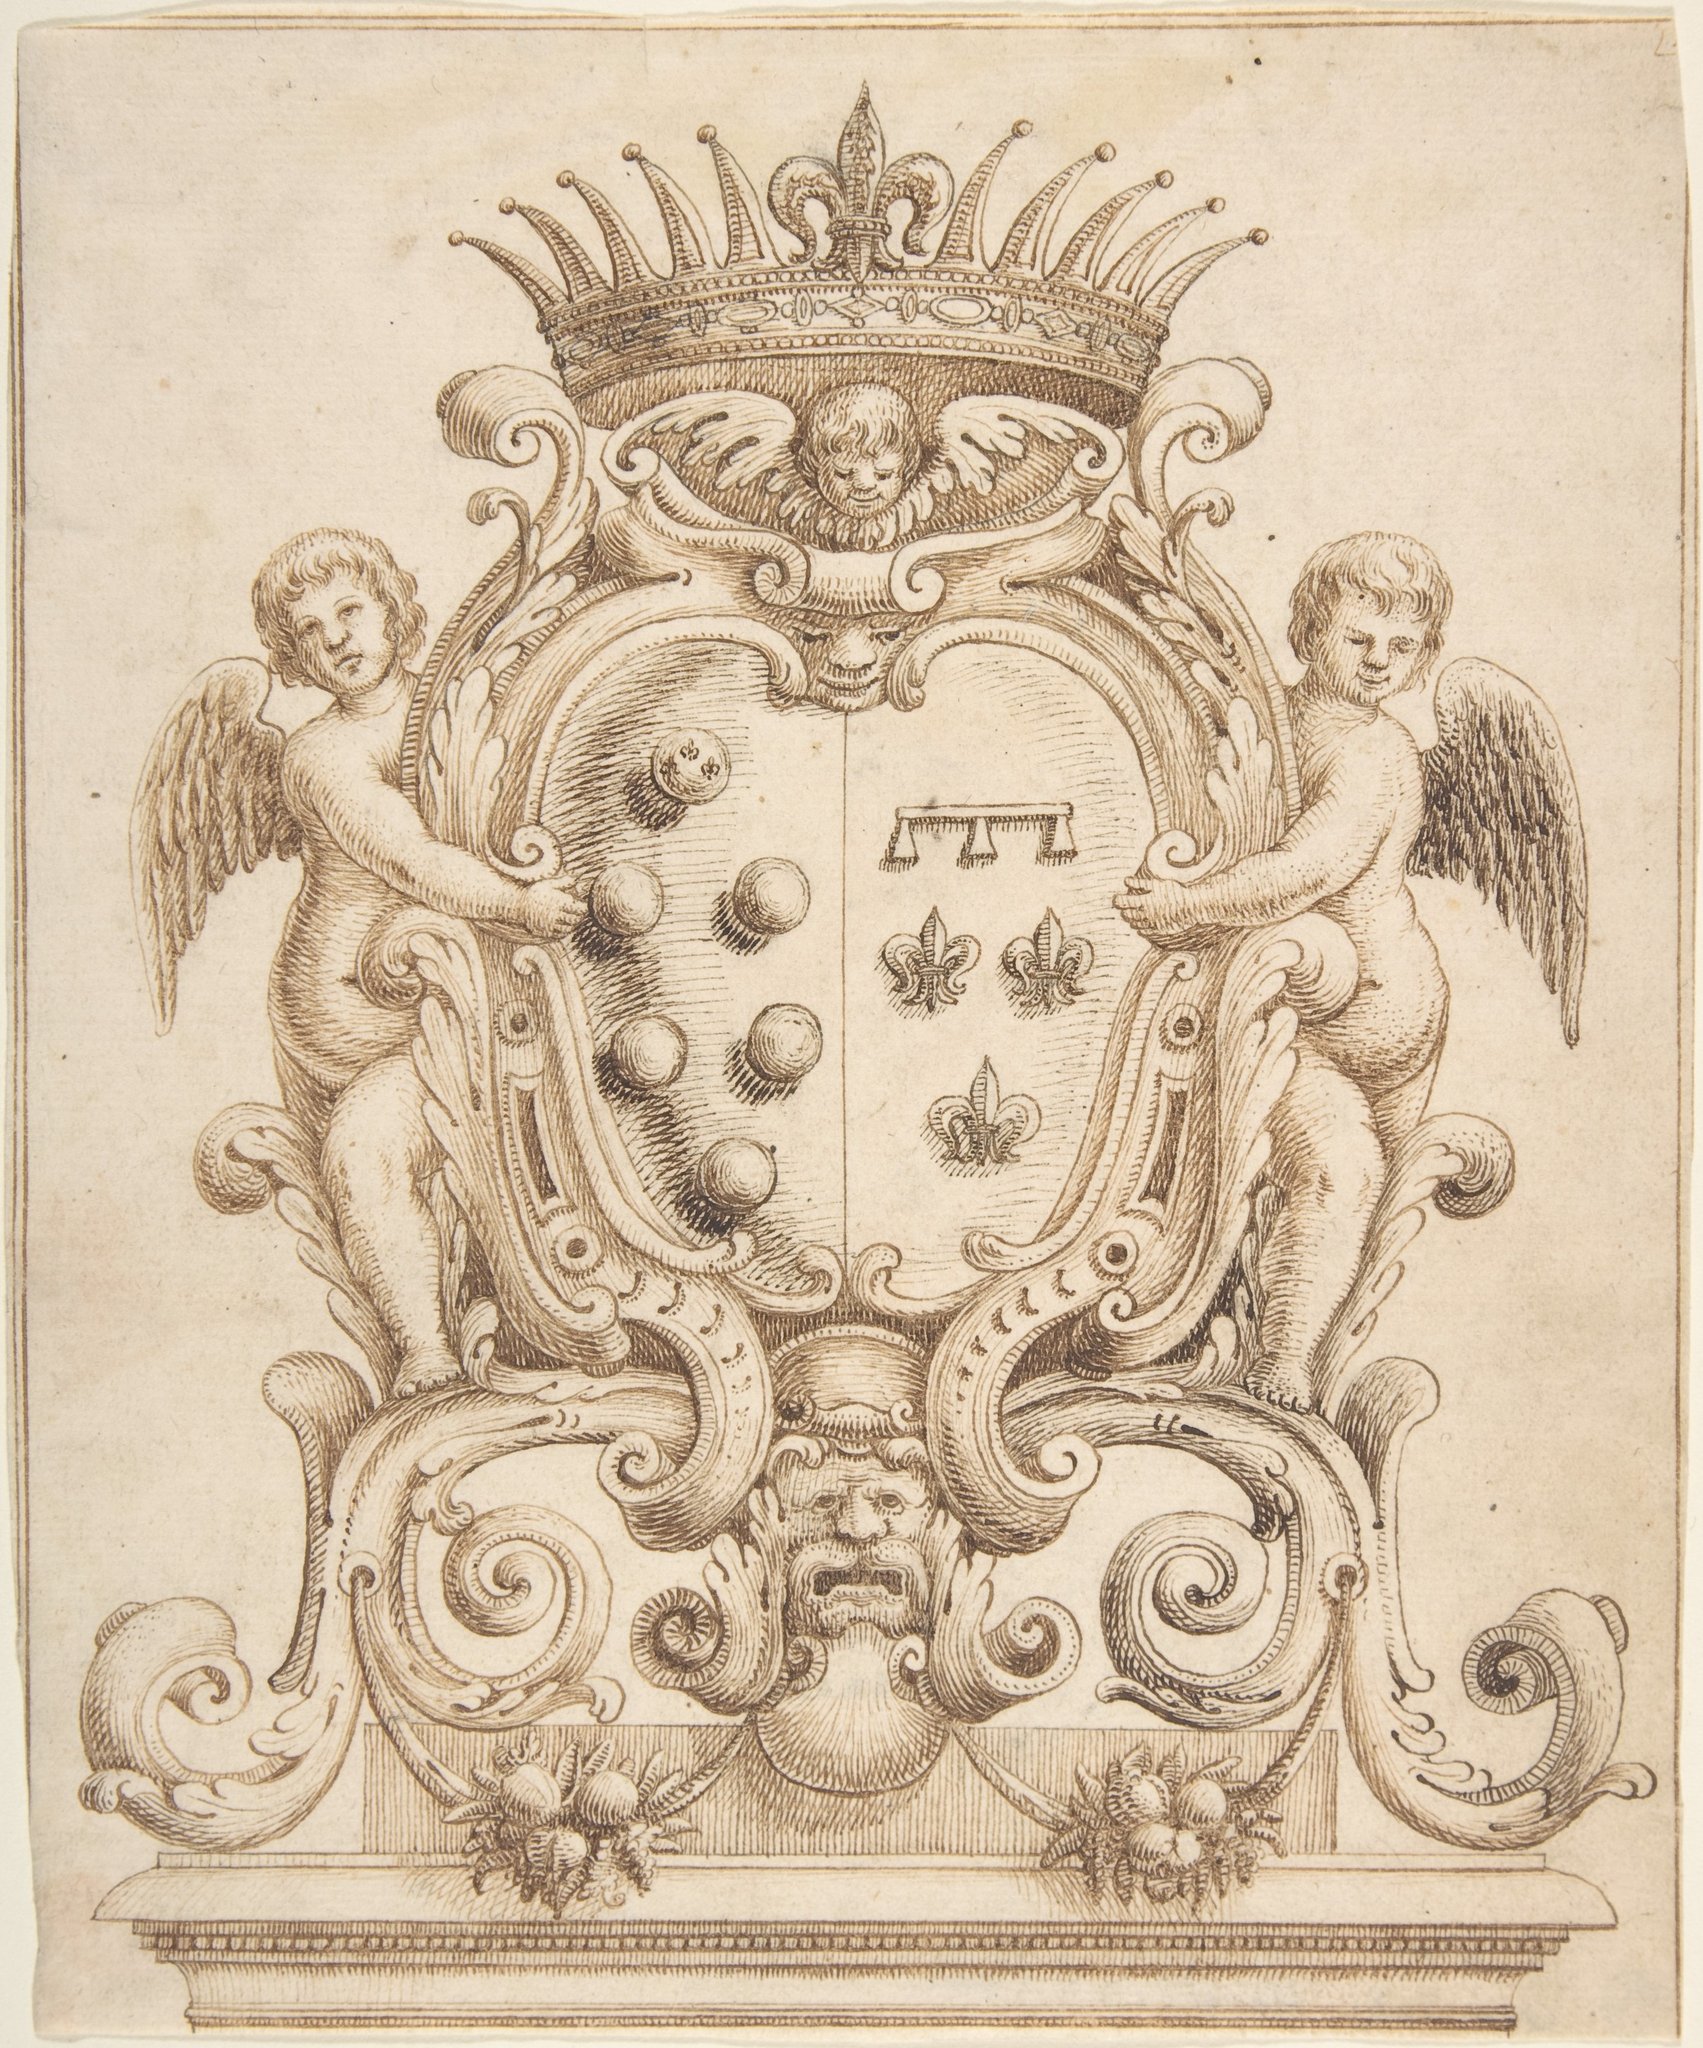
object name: drawing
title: Heraldic Design for Henry IV and Marie de Medici (?)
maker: anonymous, french, 17th century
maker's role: artist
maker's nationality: french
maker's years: 1600-1700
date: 1601-1700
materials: ink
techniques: pen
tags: coat of arms